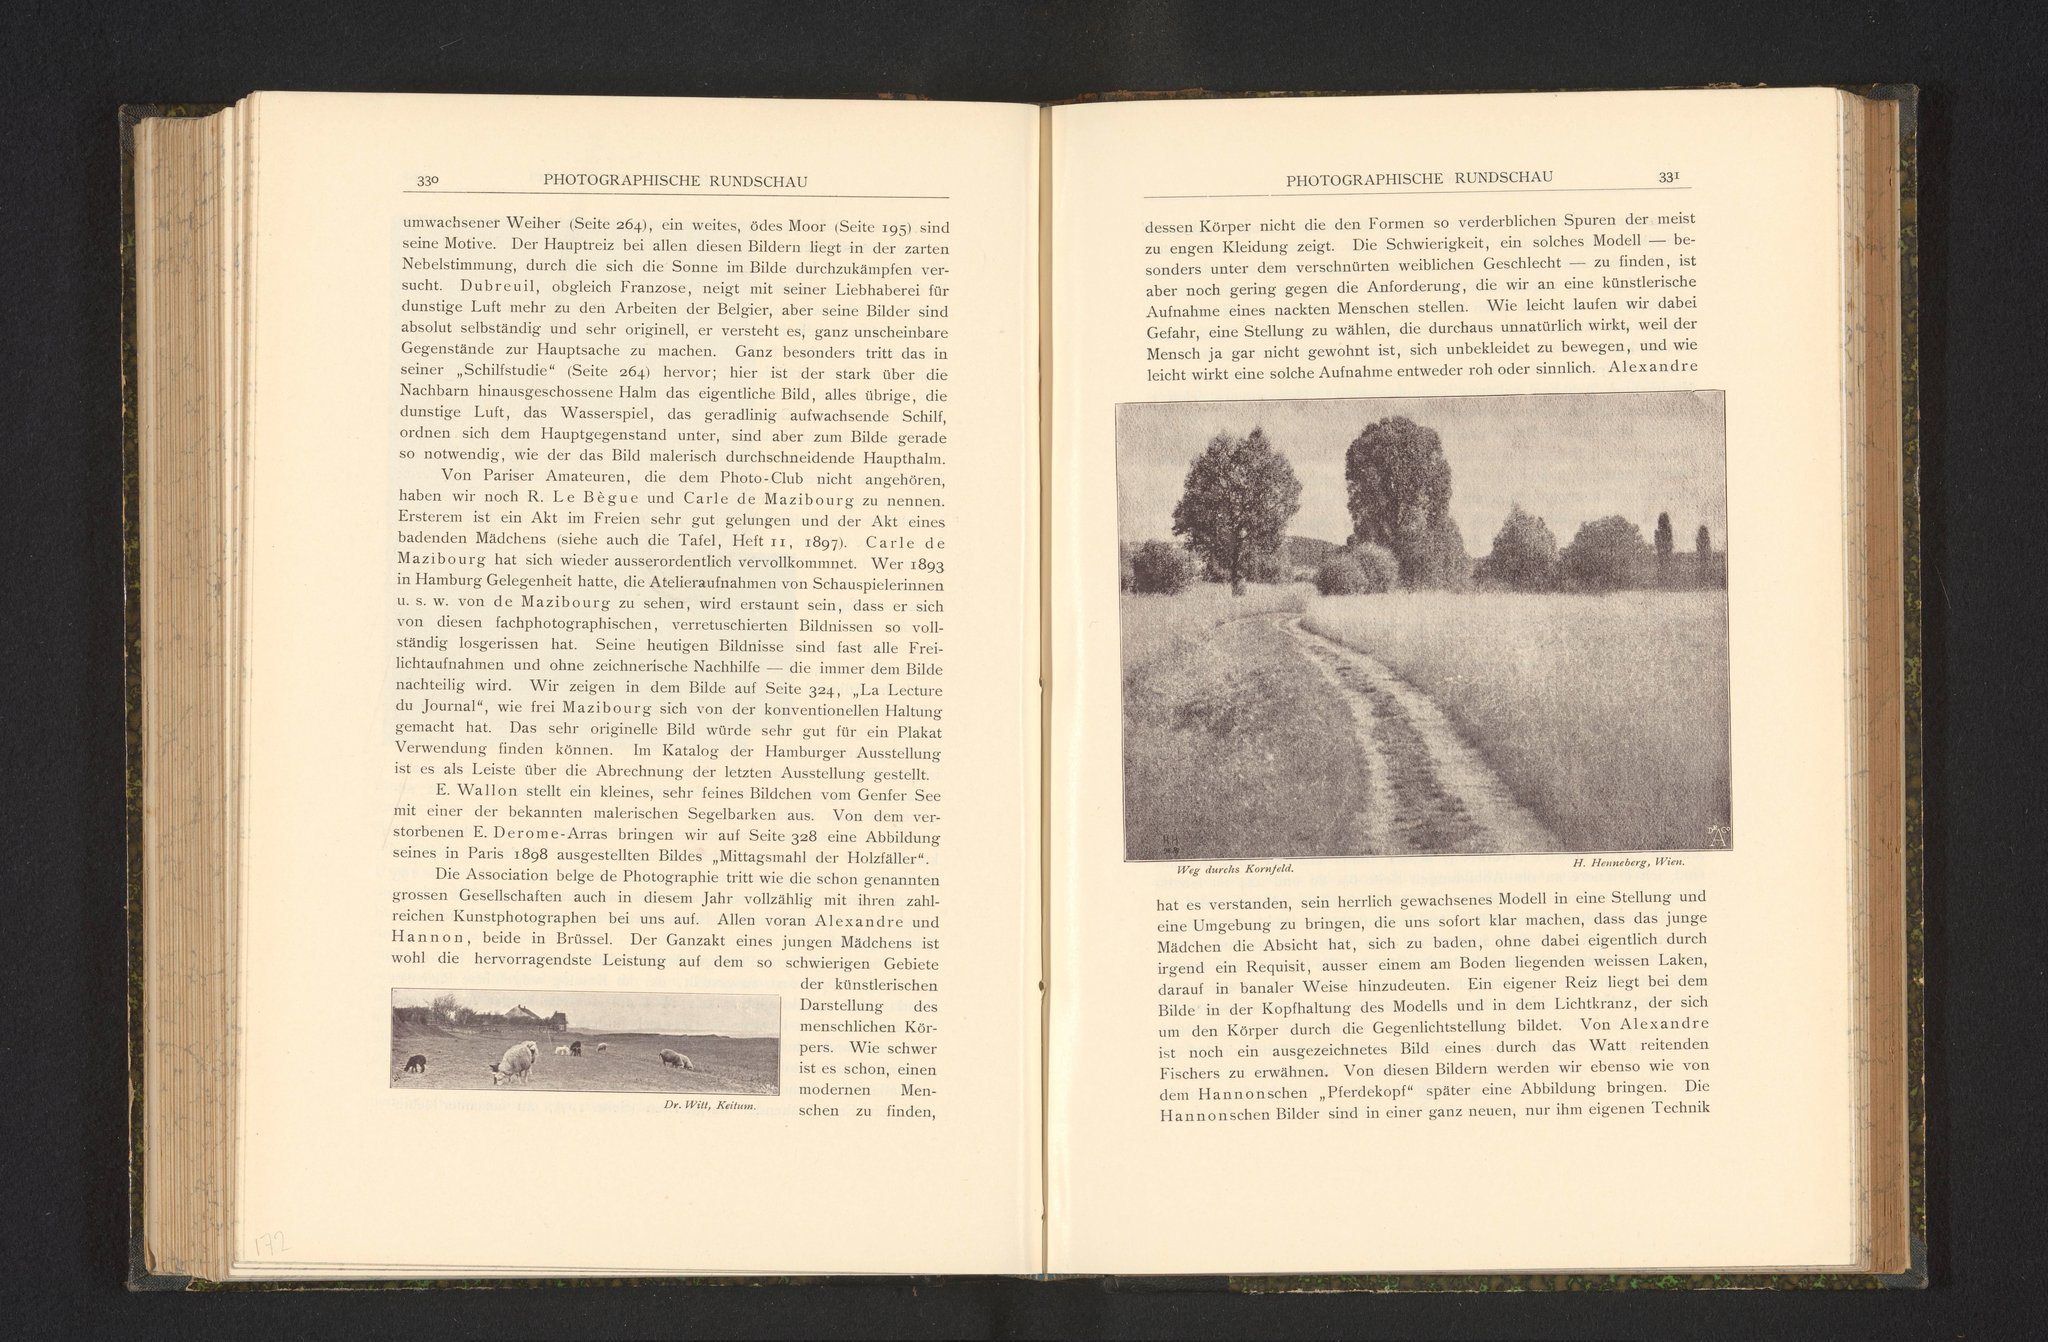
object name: page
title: Gezicht op pad dat naar bomen leidt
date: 1893-1898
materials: paper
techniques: autotype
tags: trees, road, path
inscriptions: monogram: ‘drAco’